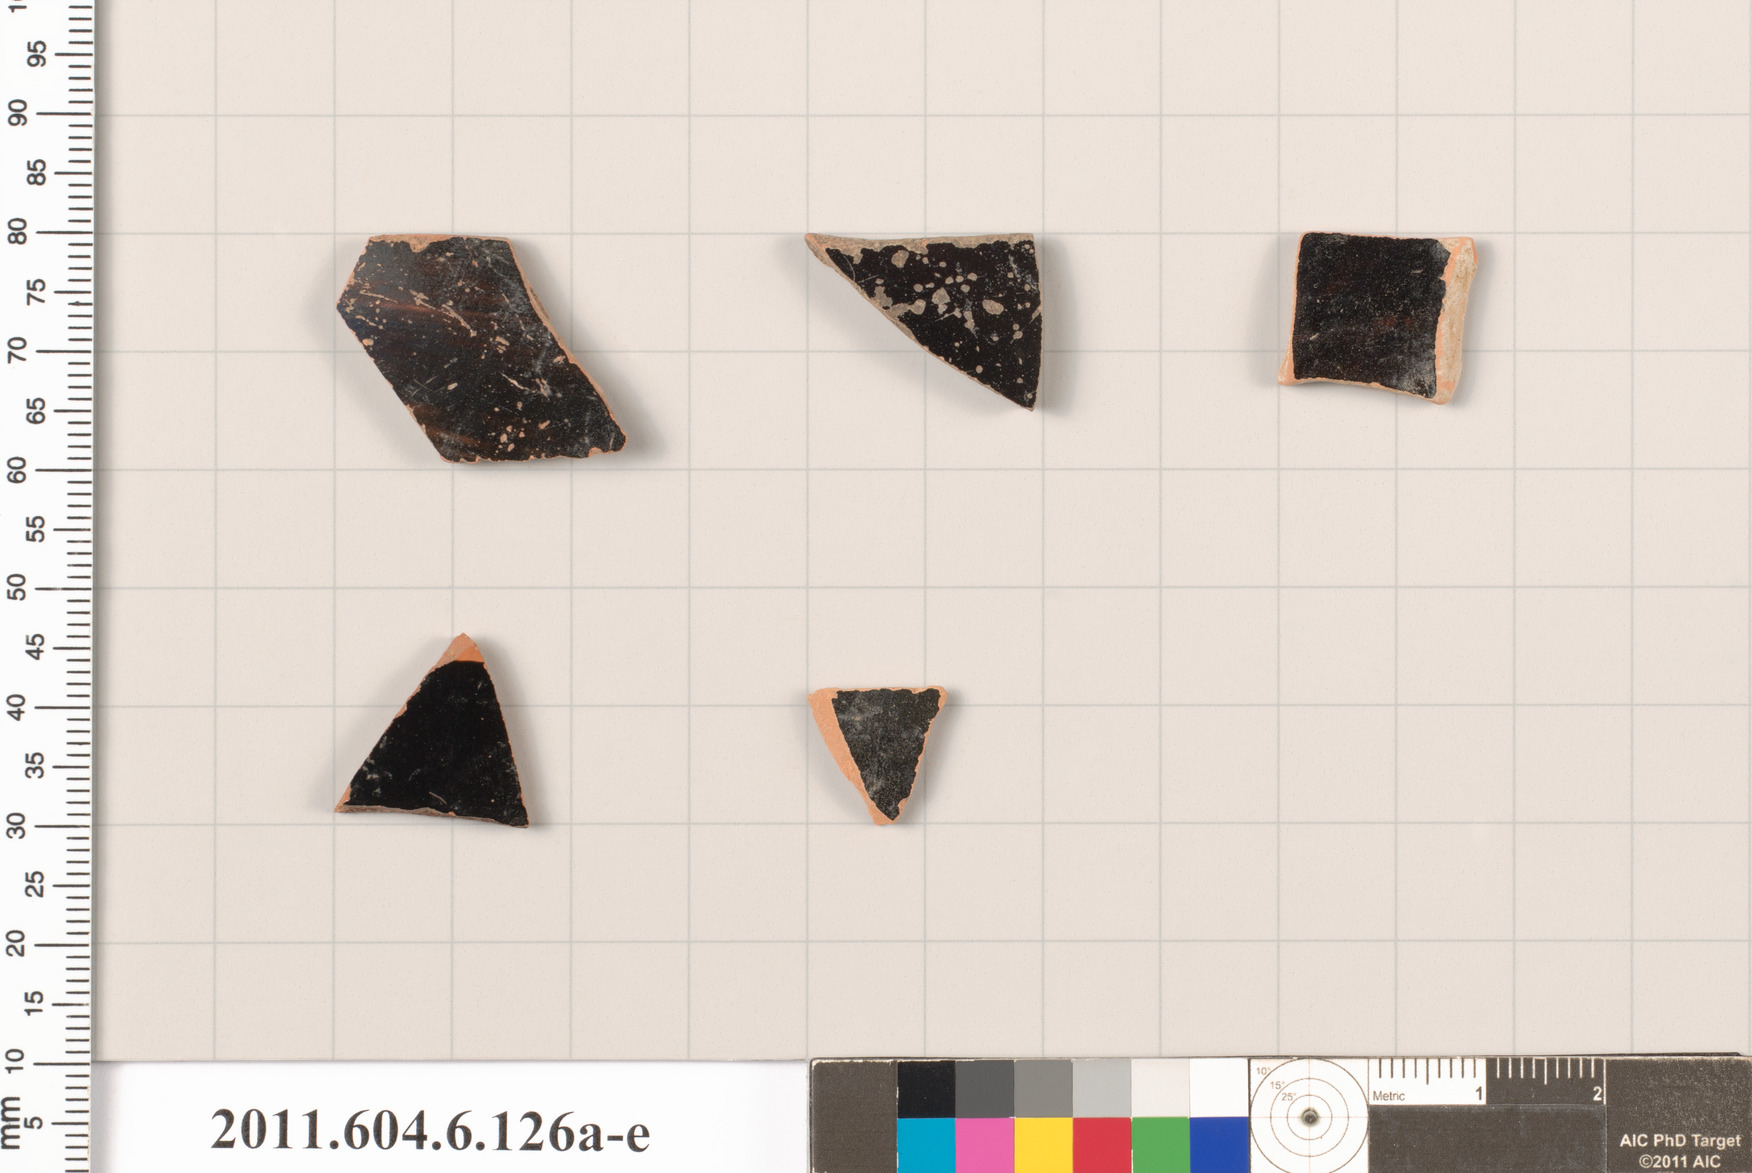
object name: undetermined closed shape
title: Terracotta fragments of closed shapes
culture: greek, attic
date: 600-401 BCE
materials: terracotta